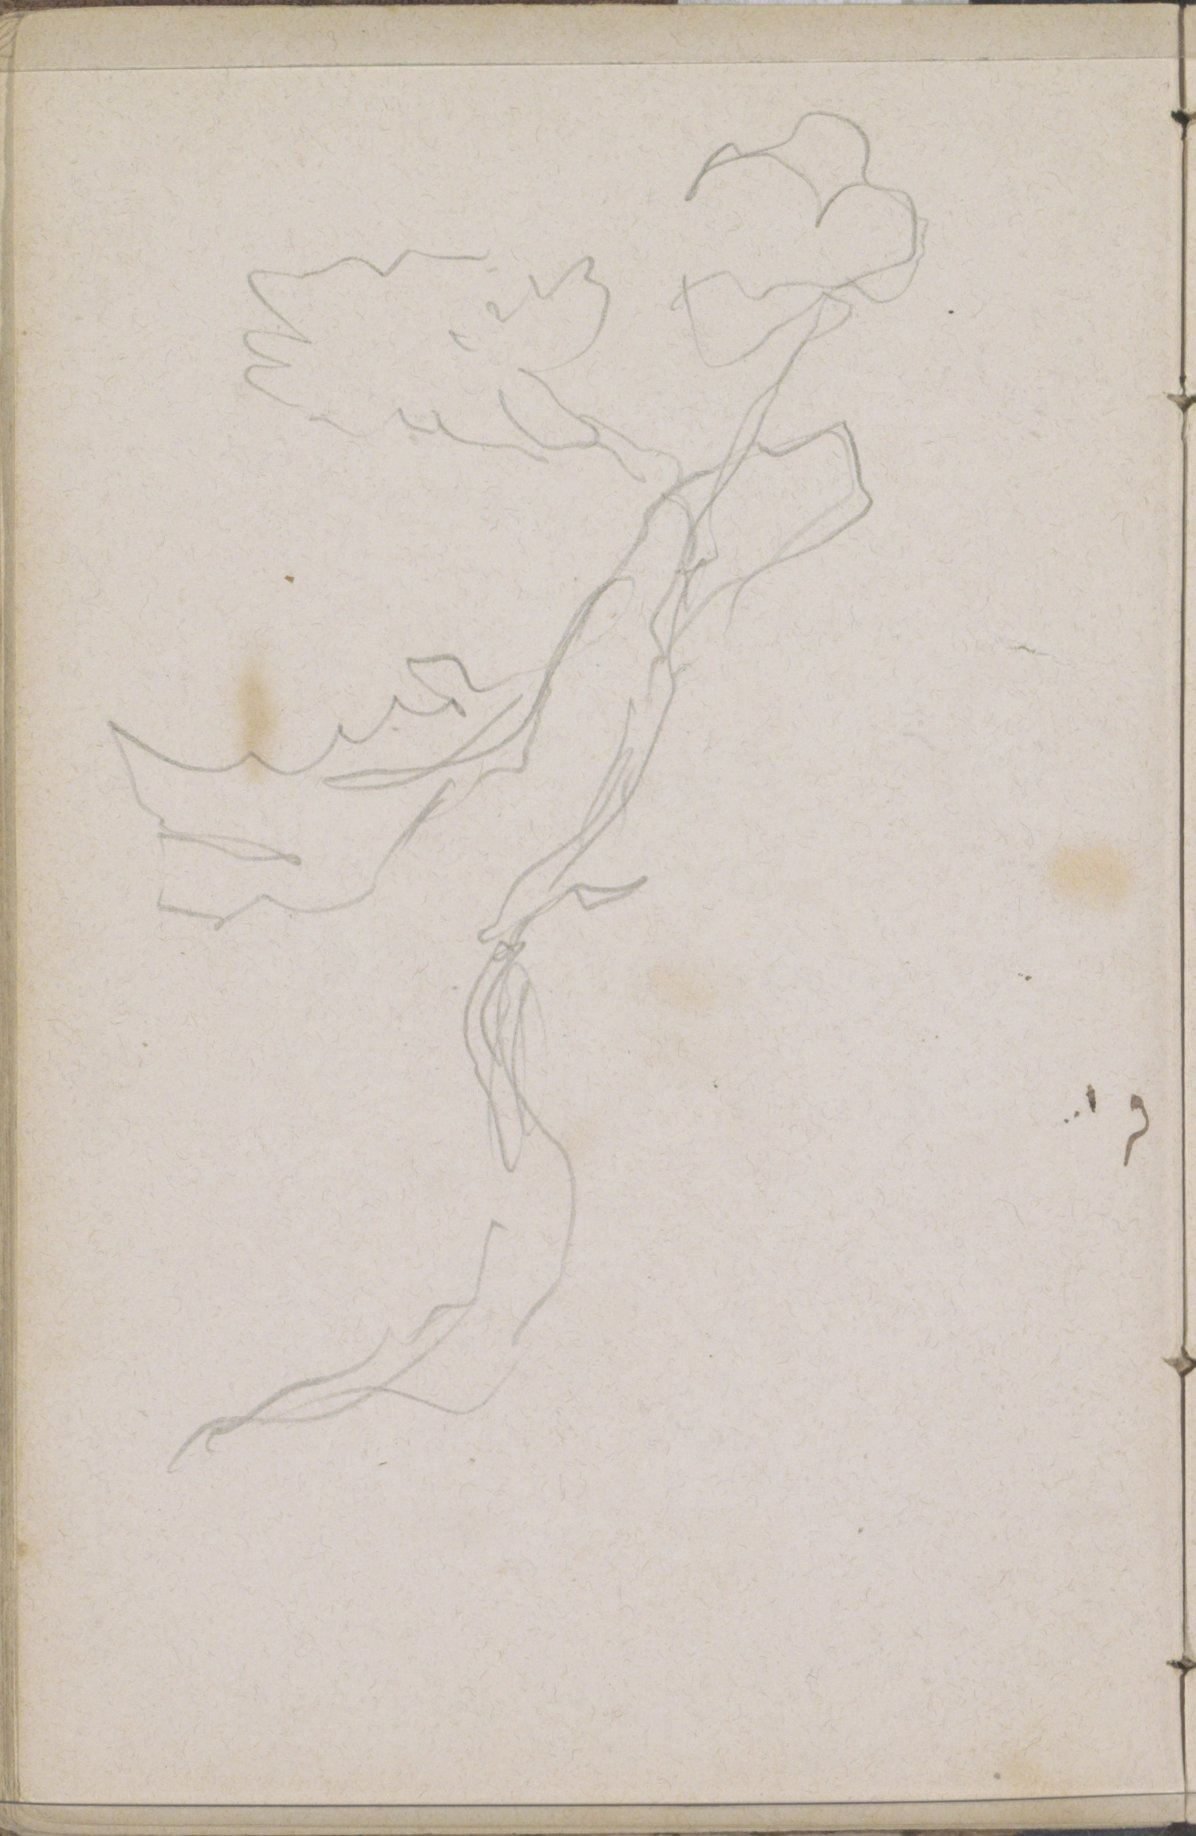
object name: sketchbook leaf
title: Tak van een plant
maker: johannes tavenraat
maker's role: draughtsman, painter, print maker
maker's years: 1809-1881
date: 1862-1864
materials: paper, pencil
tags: plants (in general)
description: Blad 27 verso uit een schetsboek met 65 bladen.